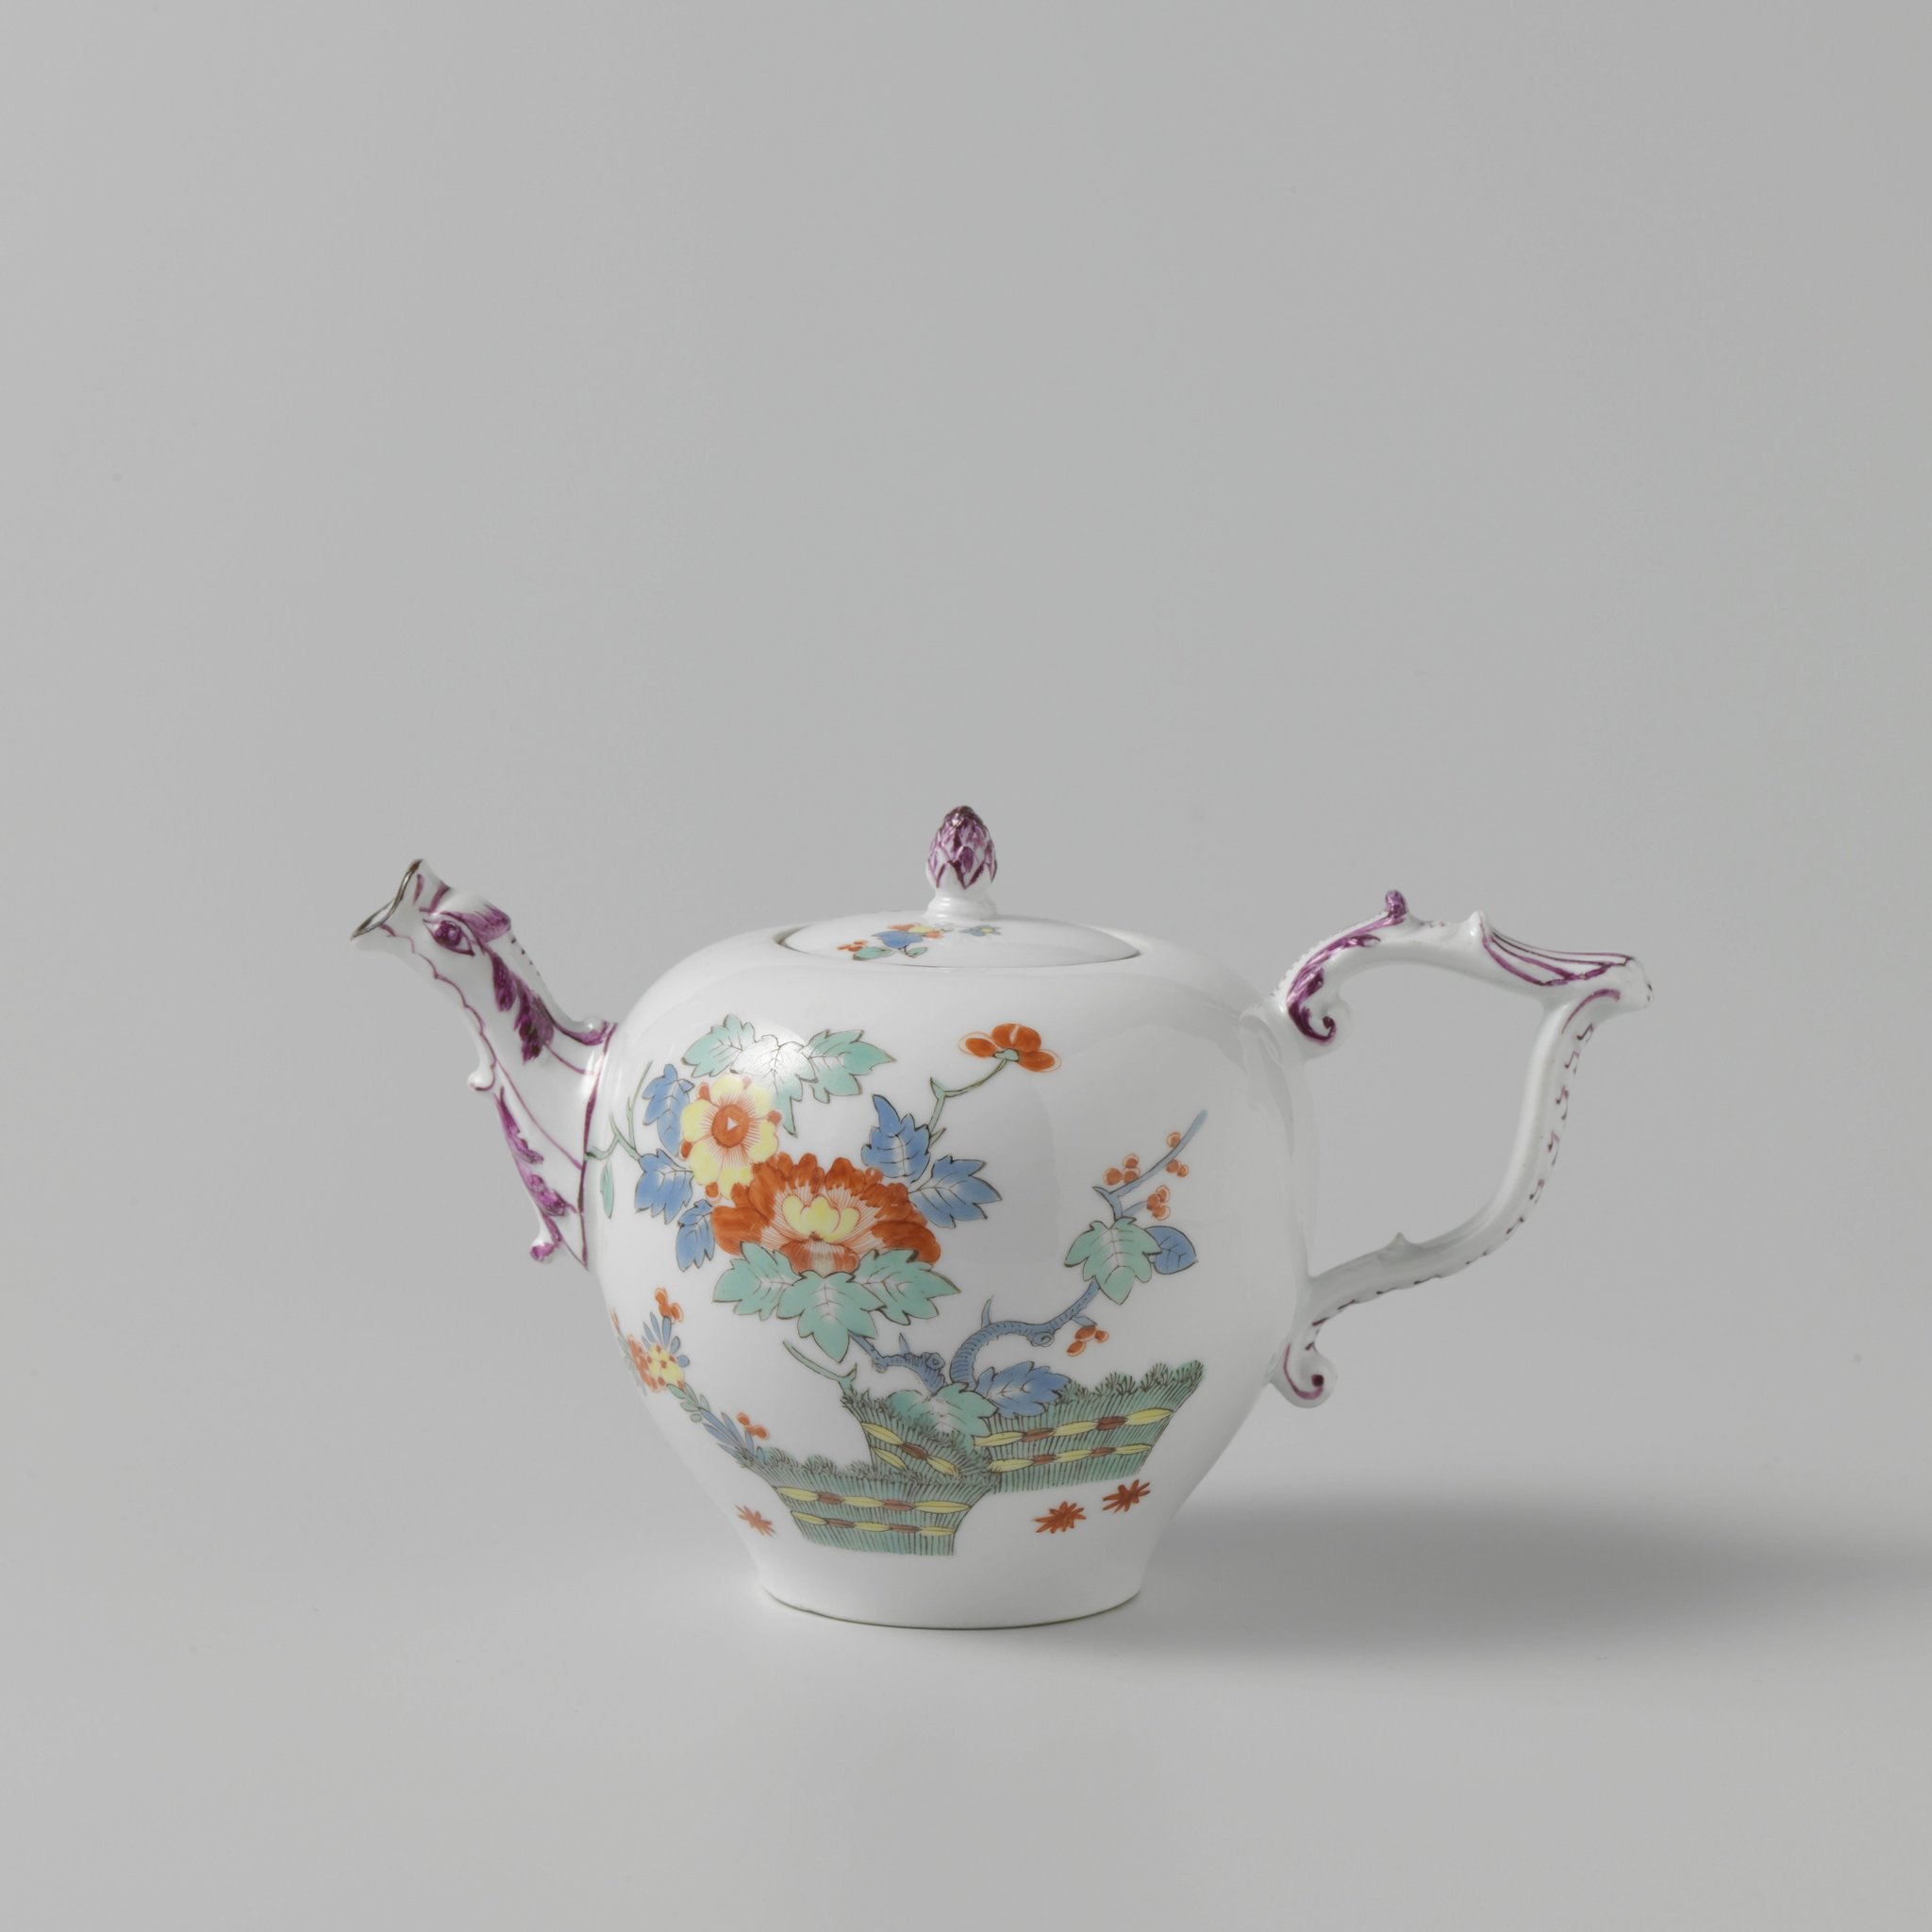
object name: teapot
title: Theepot met deksel, veelkleurig beschilderd met een Kakiemon-decor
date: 1735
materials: porcelain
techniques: painted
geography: meissen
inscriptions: factory mark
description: Tea pot. Porcelain. Meissen, c. 1735.